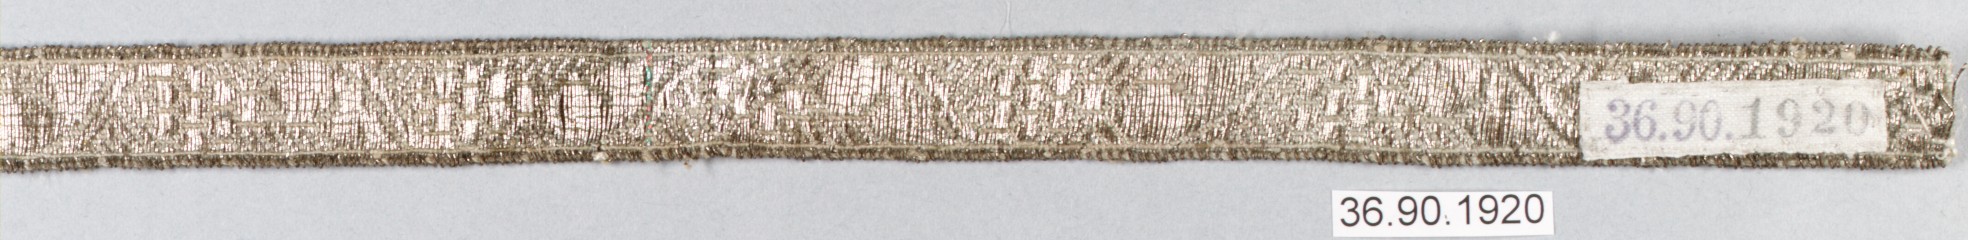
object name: galloon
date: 1767-1833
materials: metal thread, silk